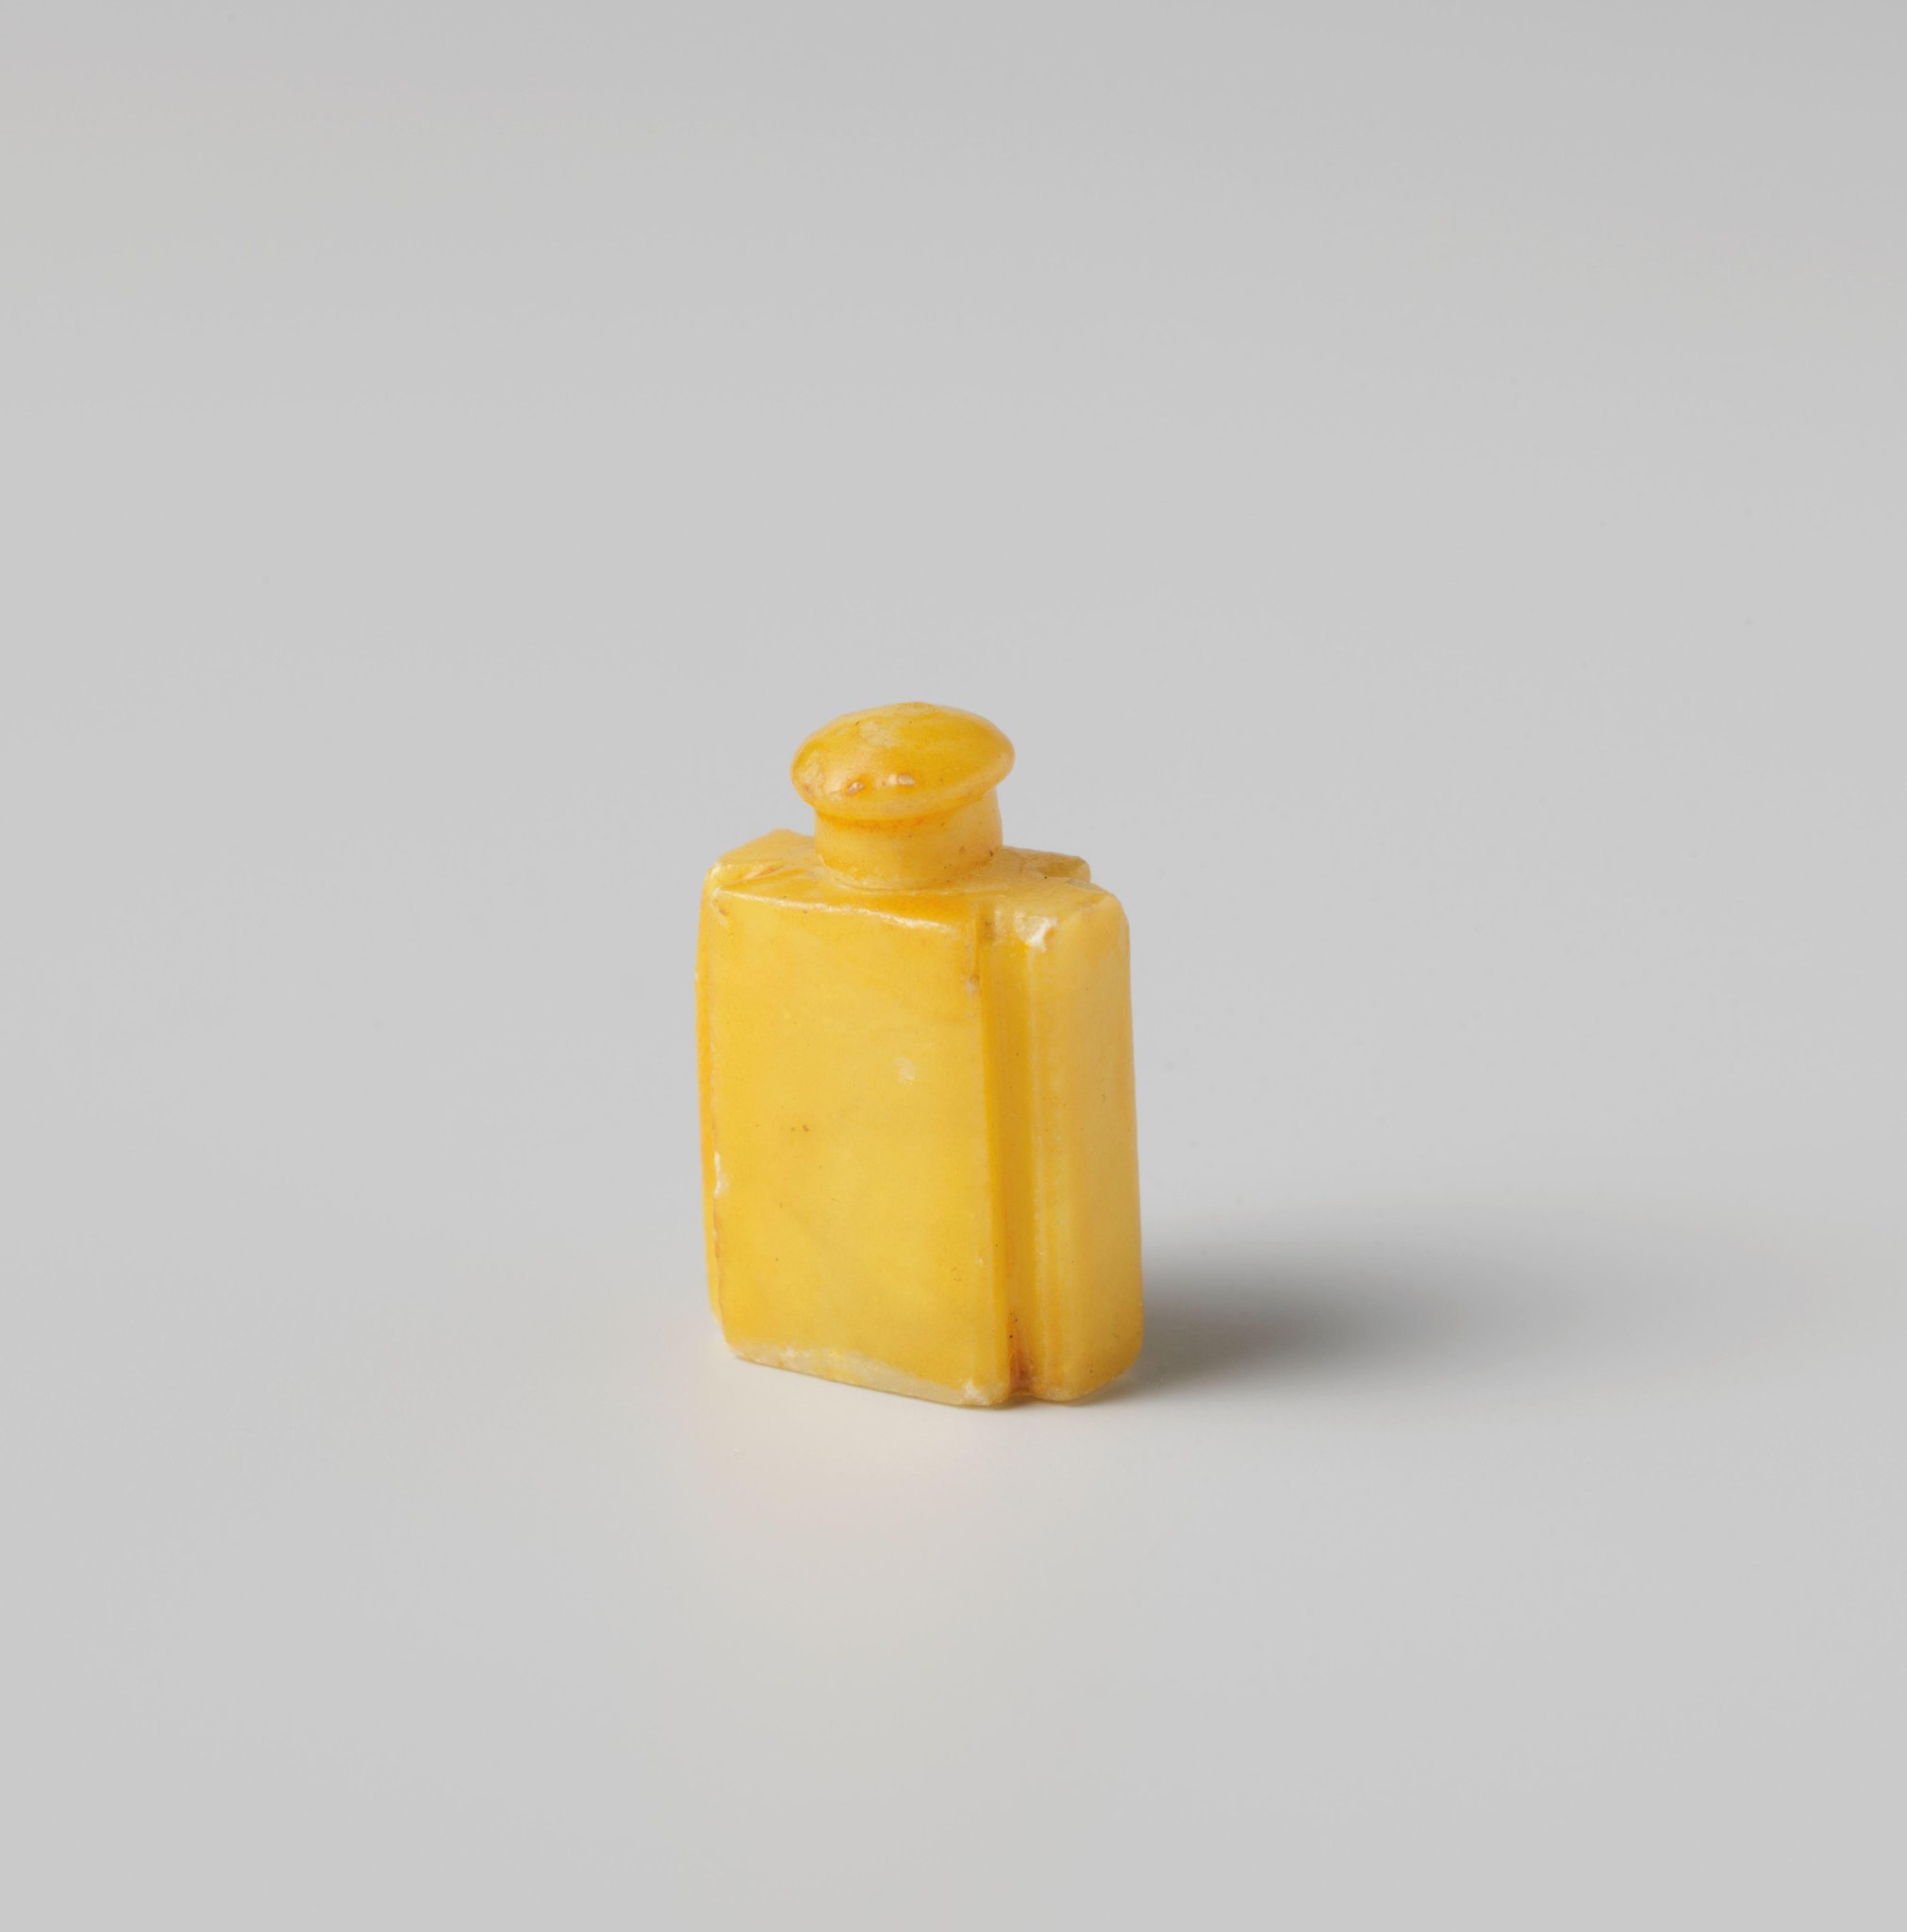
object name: miniature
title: Theebus met dop, geelgelakt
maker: Anonymous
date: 1750-1800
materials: alabaster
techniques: lacquer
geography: germany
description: Theebus van geelgelakt albast. De bus heeft een rechthoekige vorm met inzwenkende hoeken. De bus is massief met een kleine uitholling en een losse gladde dop.